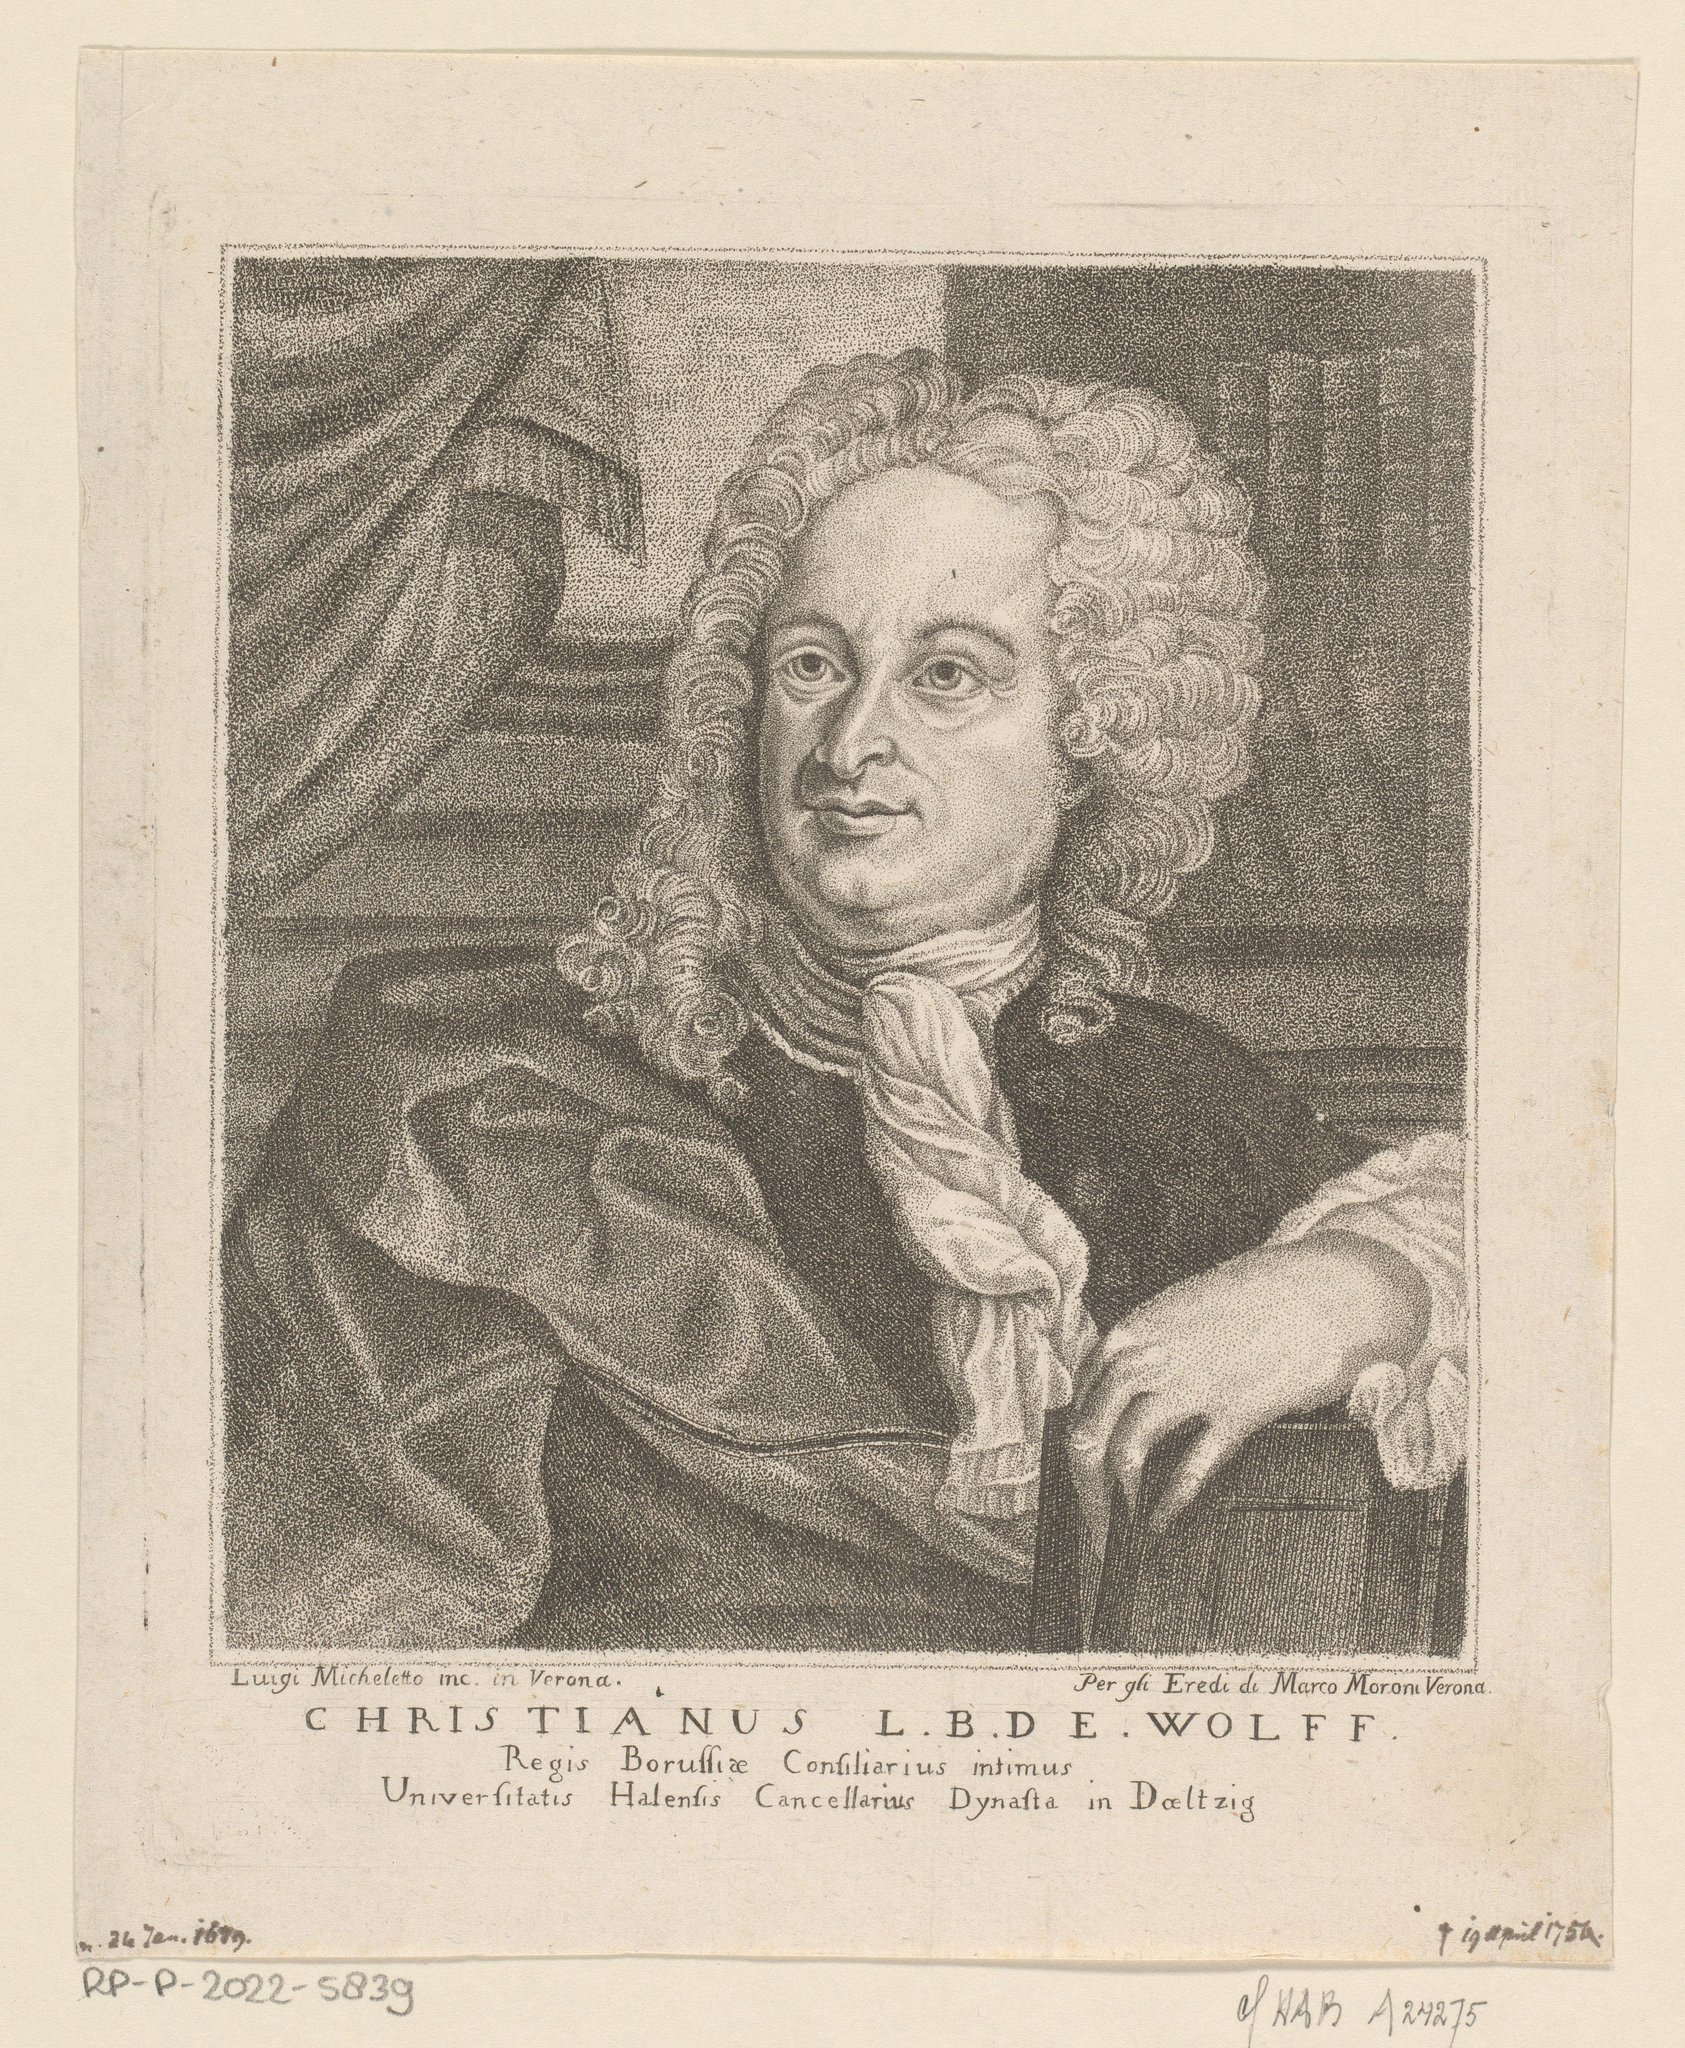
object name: print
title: Portret van Christian Wolff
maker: luigi michelotto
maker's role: print maker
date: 1778-1820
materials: paper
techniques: stippling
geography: verona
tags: scholar, philosopher, historical persons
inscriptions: inscription: ‘n. 24 Jan 1679 + 19 april 1754.’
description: Met tweeregelig onderschrift in het Latijn.